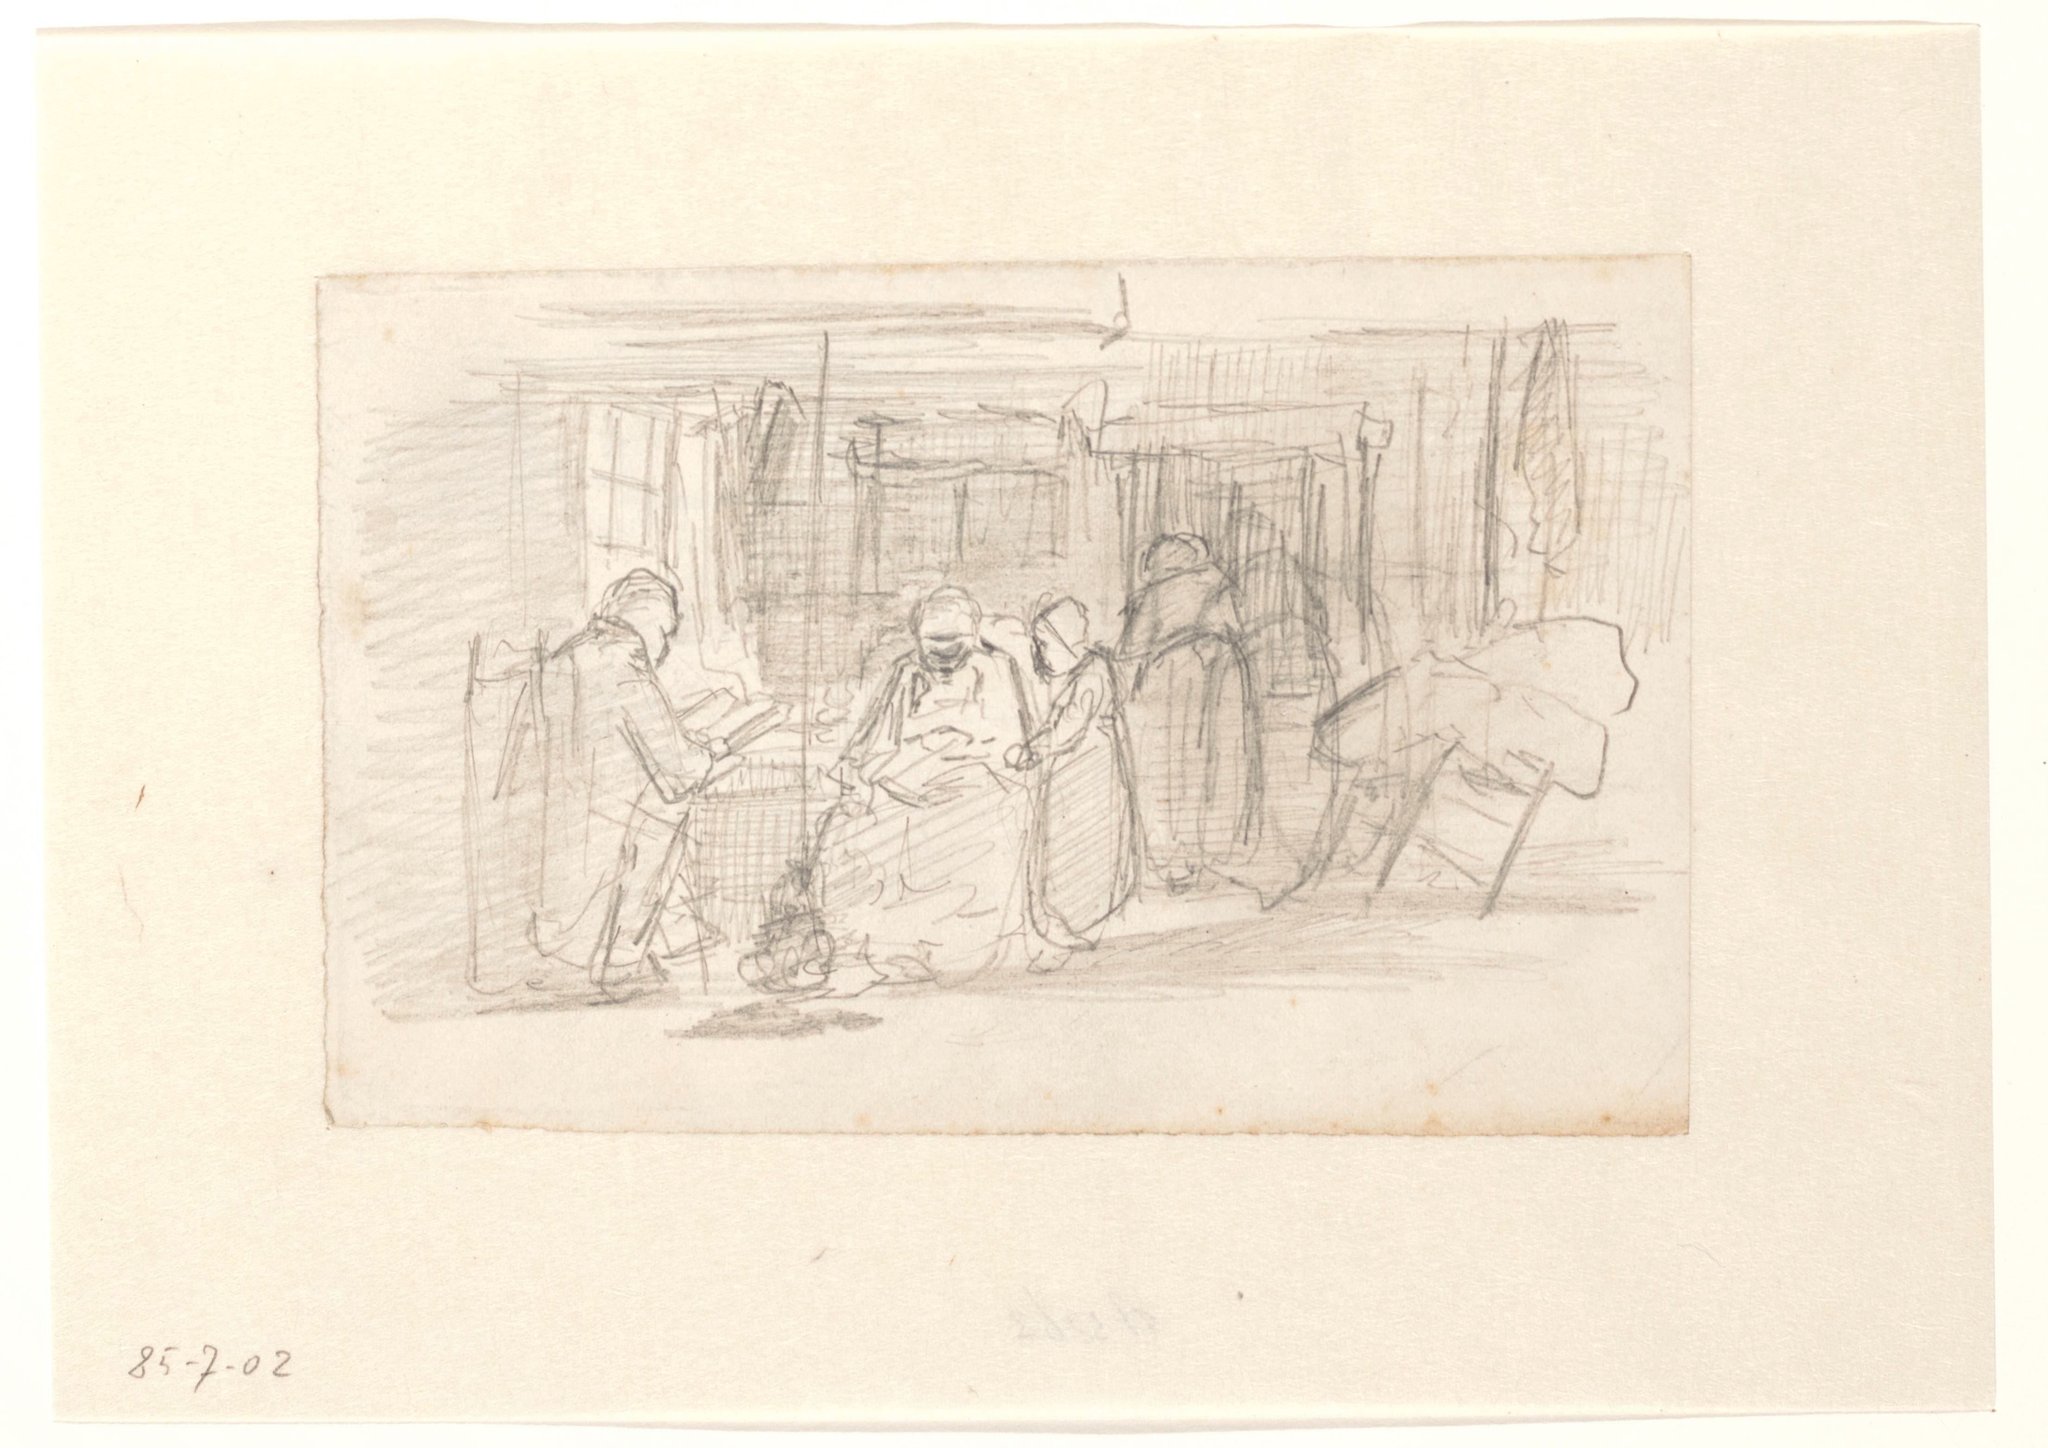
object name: drawing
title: Interieur met familie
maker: hendrik valkenburg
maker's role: draughtsman, painter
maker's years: 1826-1896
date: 1836-1896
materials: paper, pencil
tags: family group, especially parents with their child(ren), interior of the house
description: Een voorlezende man, een vrouw met een handwerkje, een meisje en een dienstbode. Verso: een staande man en breiende vrouw.